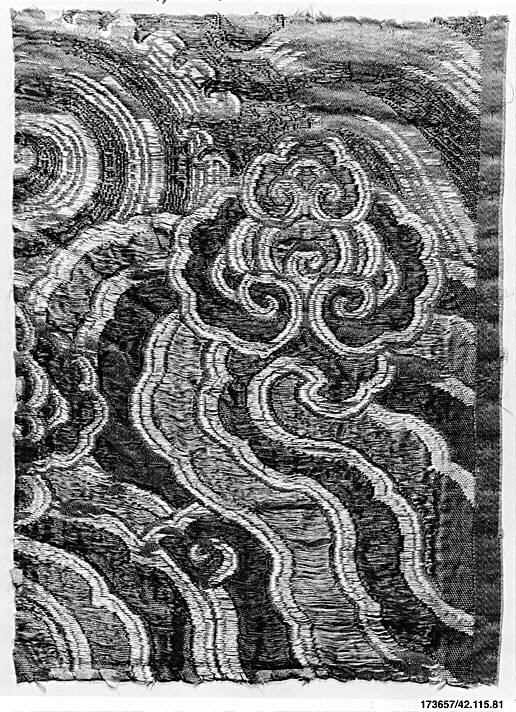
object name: border fragment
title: Border, Fragment (?)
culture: chinese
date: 1701-1733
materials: metal thread, silk